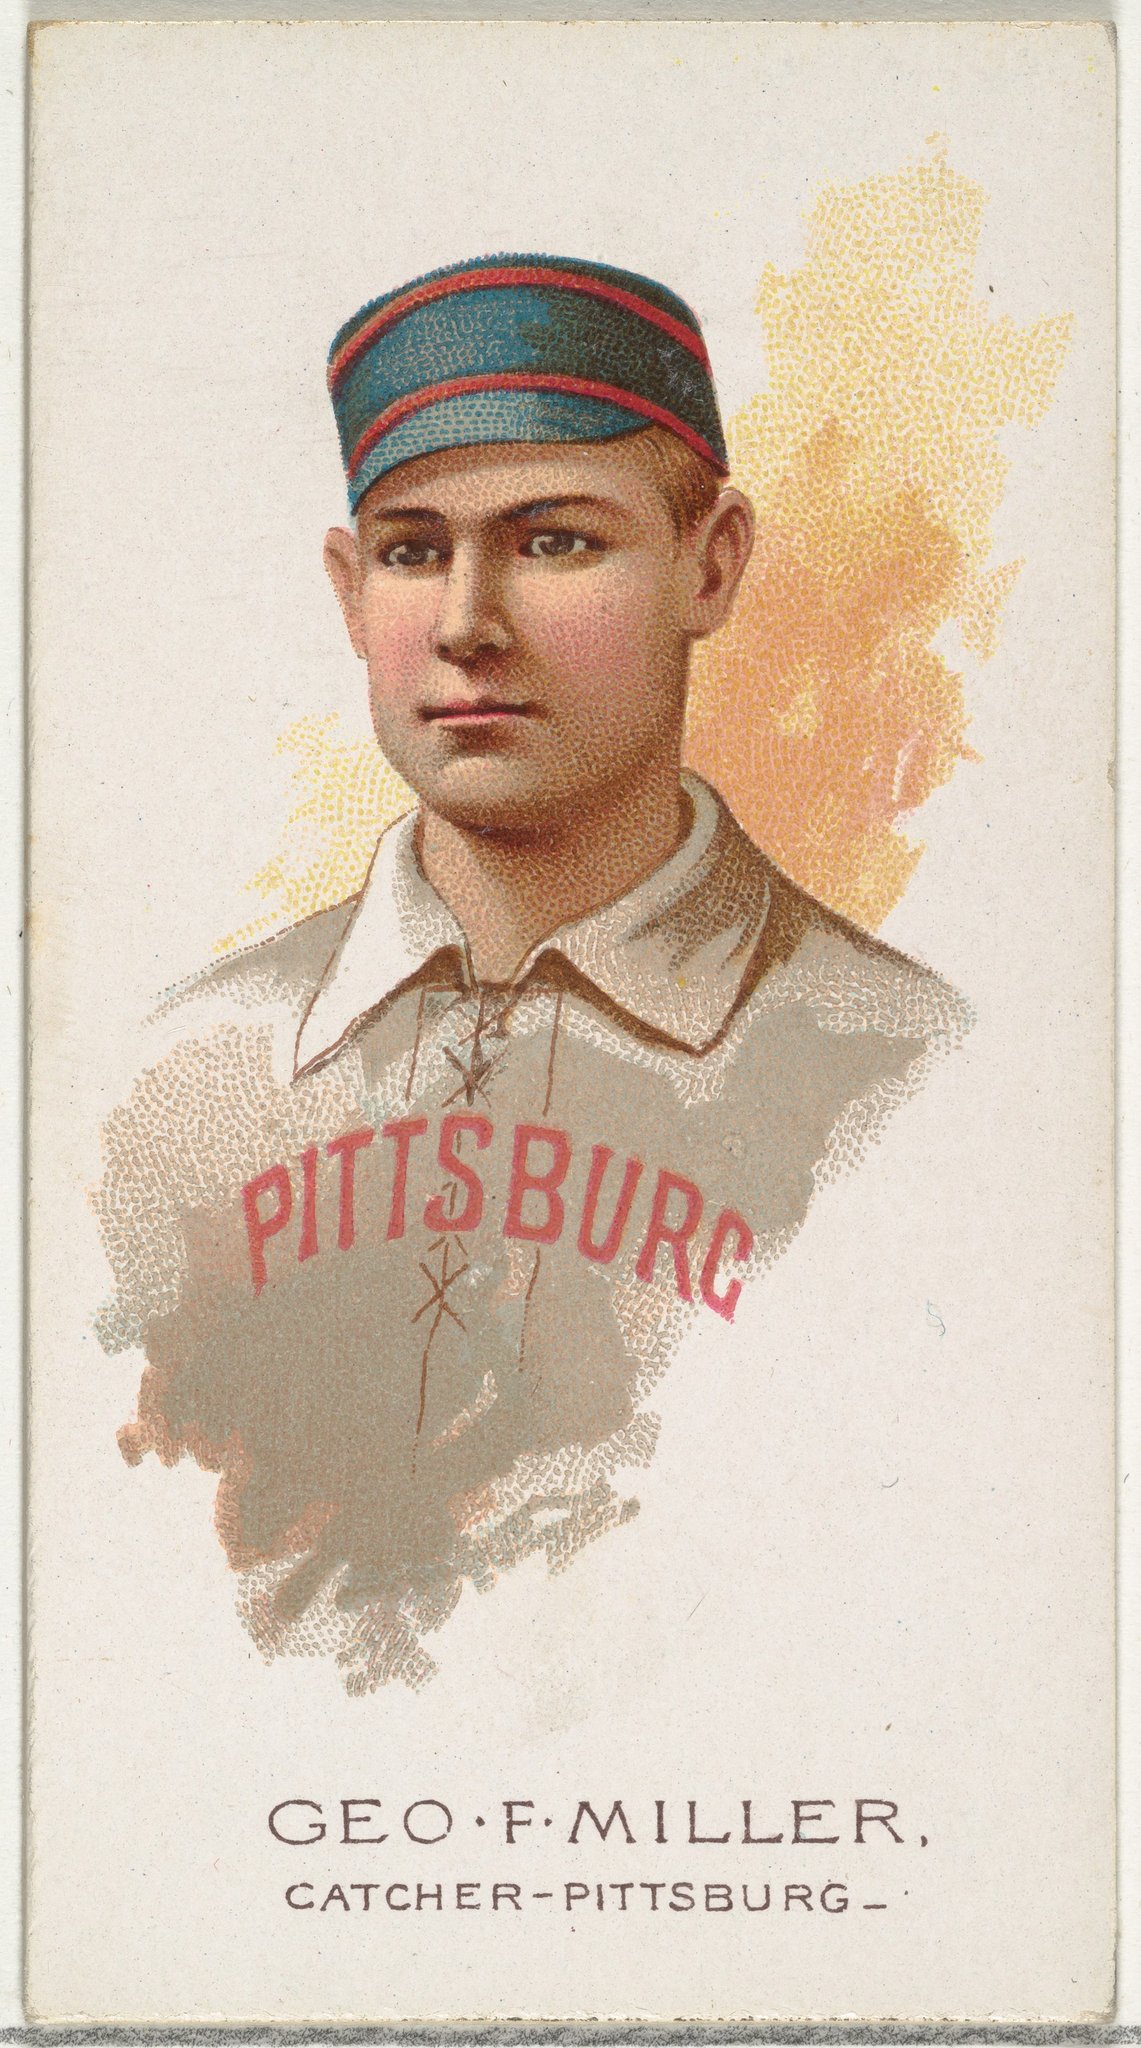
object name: baseball card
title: George F. Miller, Baseball Player, Catcher, Pittsburgh, from World's Champions, Series 2 (N29) for Allen & Ginter Cigarettes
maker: allen & ginter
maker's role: publisher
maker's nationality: american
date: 1888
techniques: color lithograph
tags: men,portraits,athletes